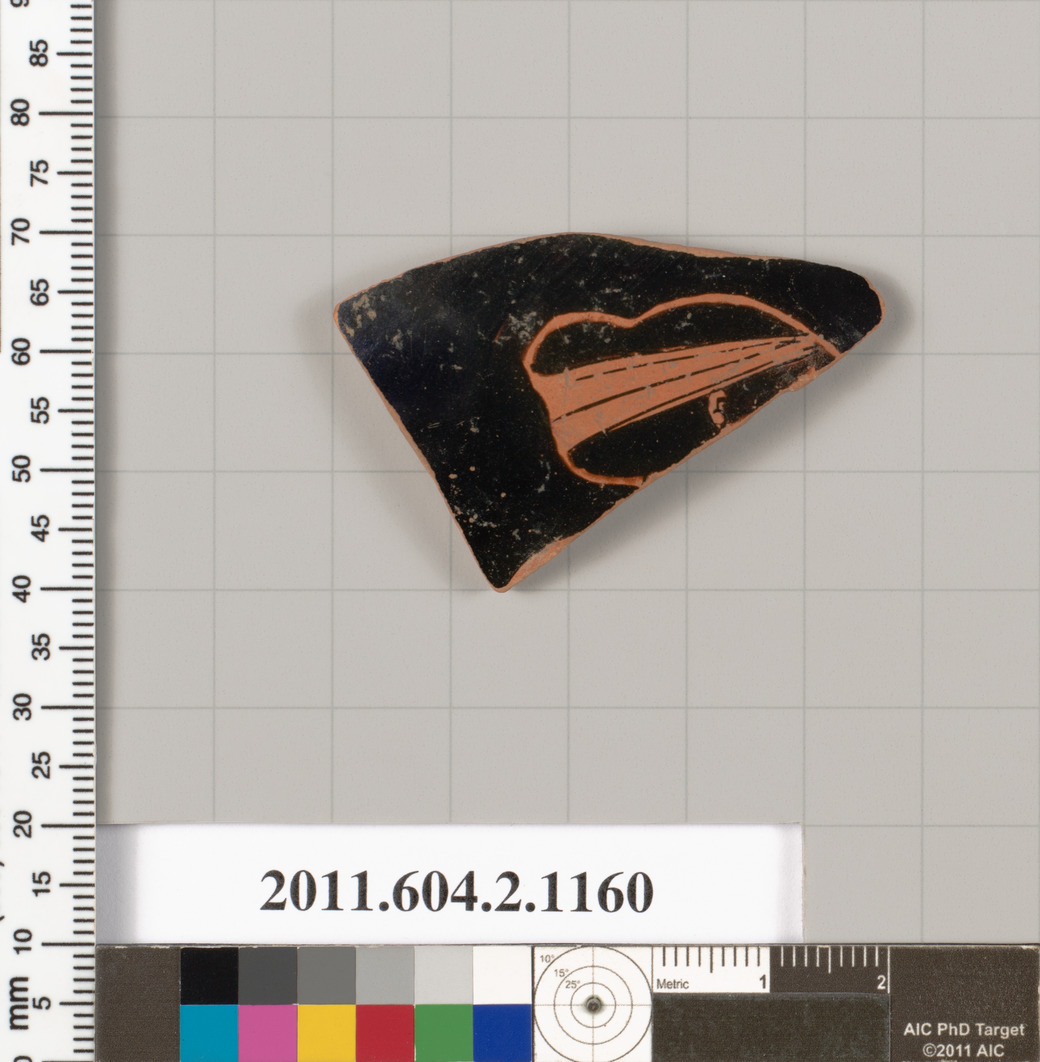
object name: oinochoe fragment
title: Terracotta fragment of an oinochoe (jug)?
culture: greek, attic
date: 475-451 BCE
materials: terracotta